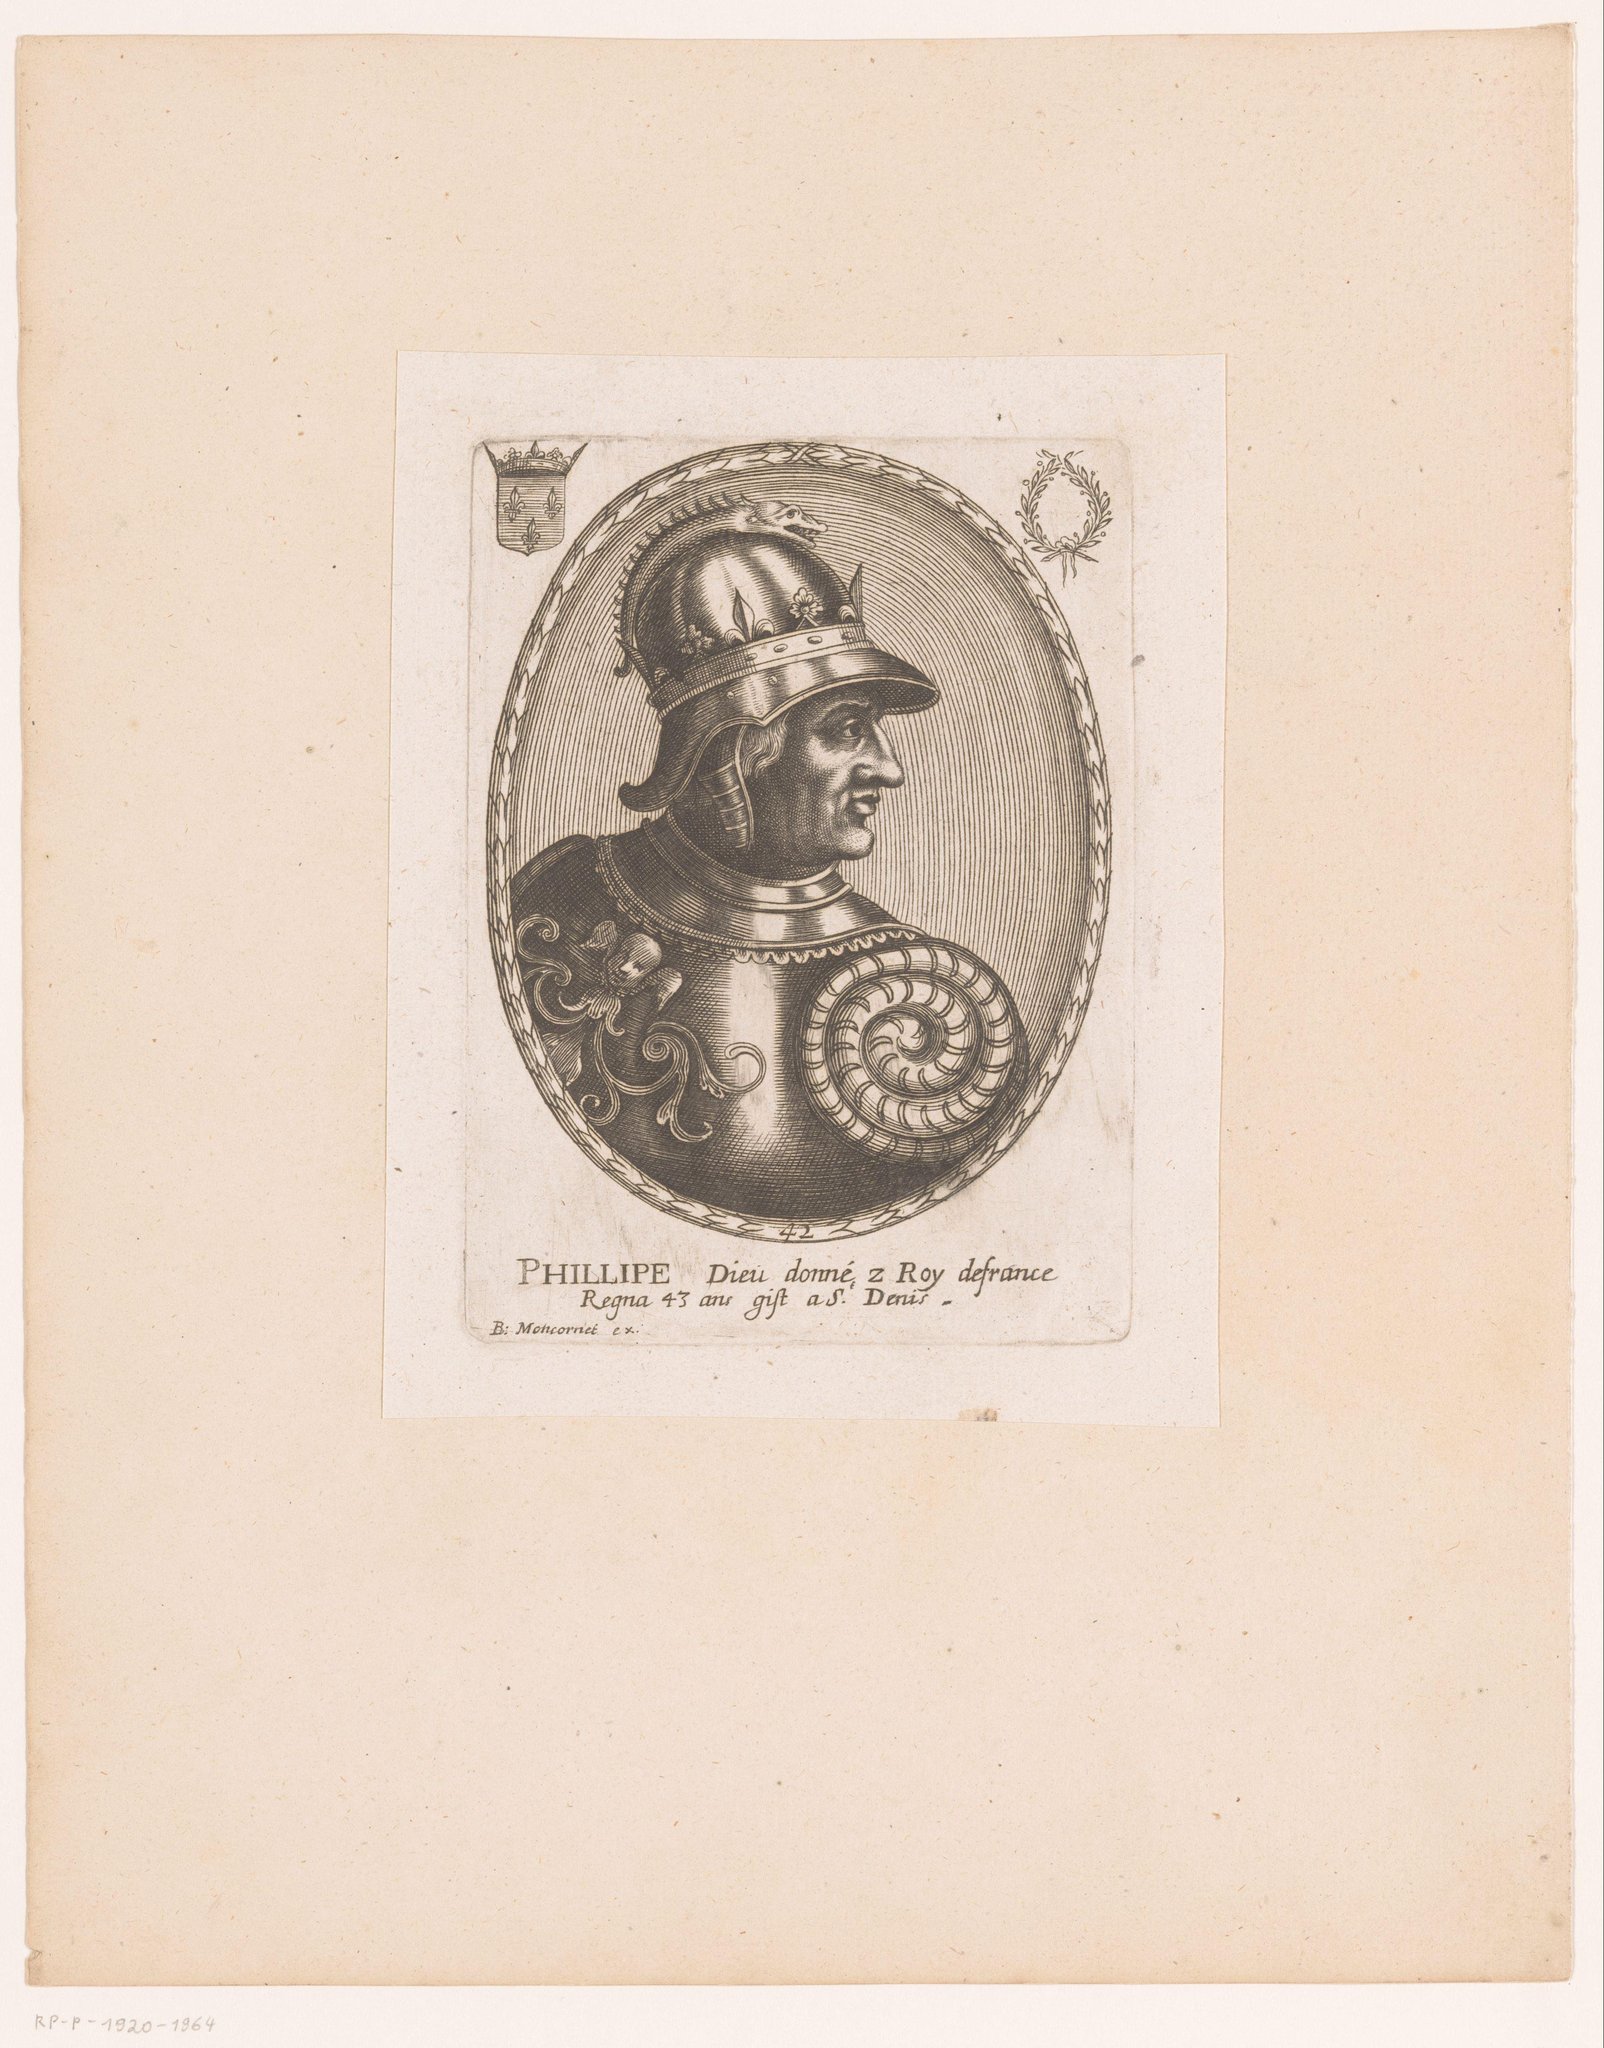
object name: print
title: Portret van Filips II van Frankrijk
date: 1610-1668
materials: paper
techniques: engraving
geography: paris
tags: paris, historical persons, king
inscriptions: collector's mark: Lugt 2228